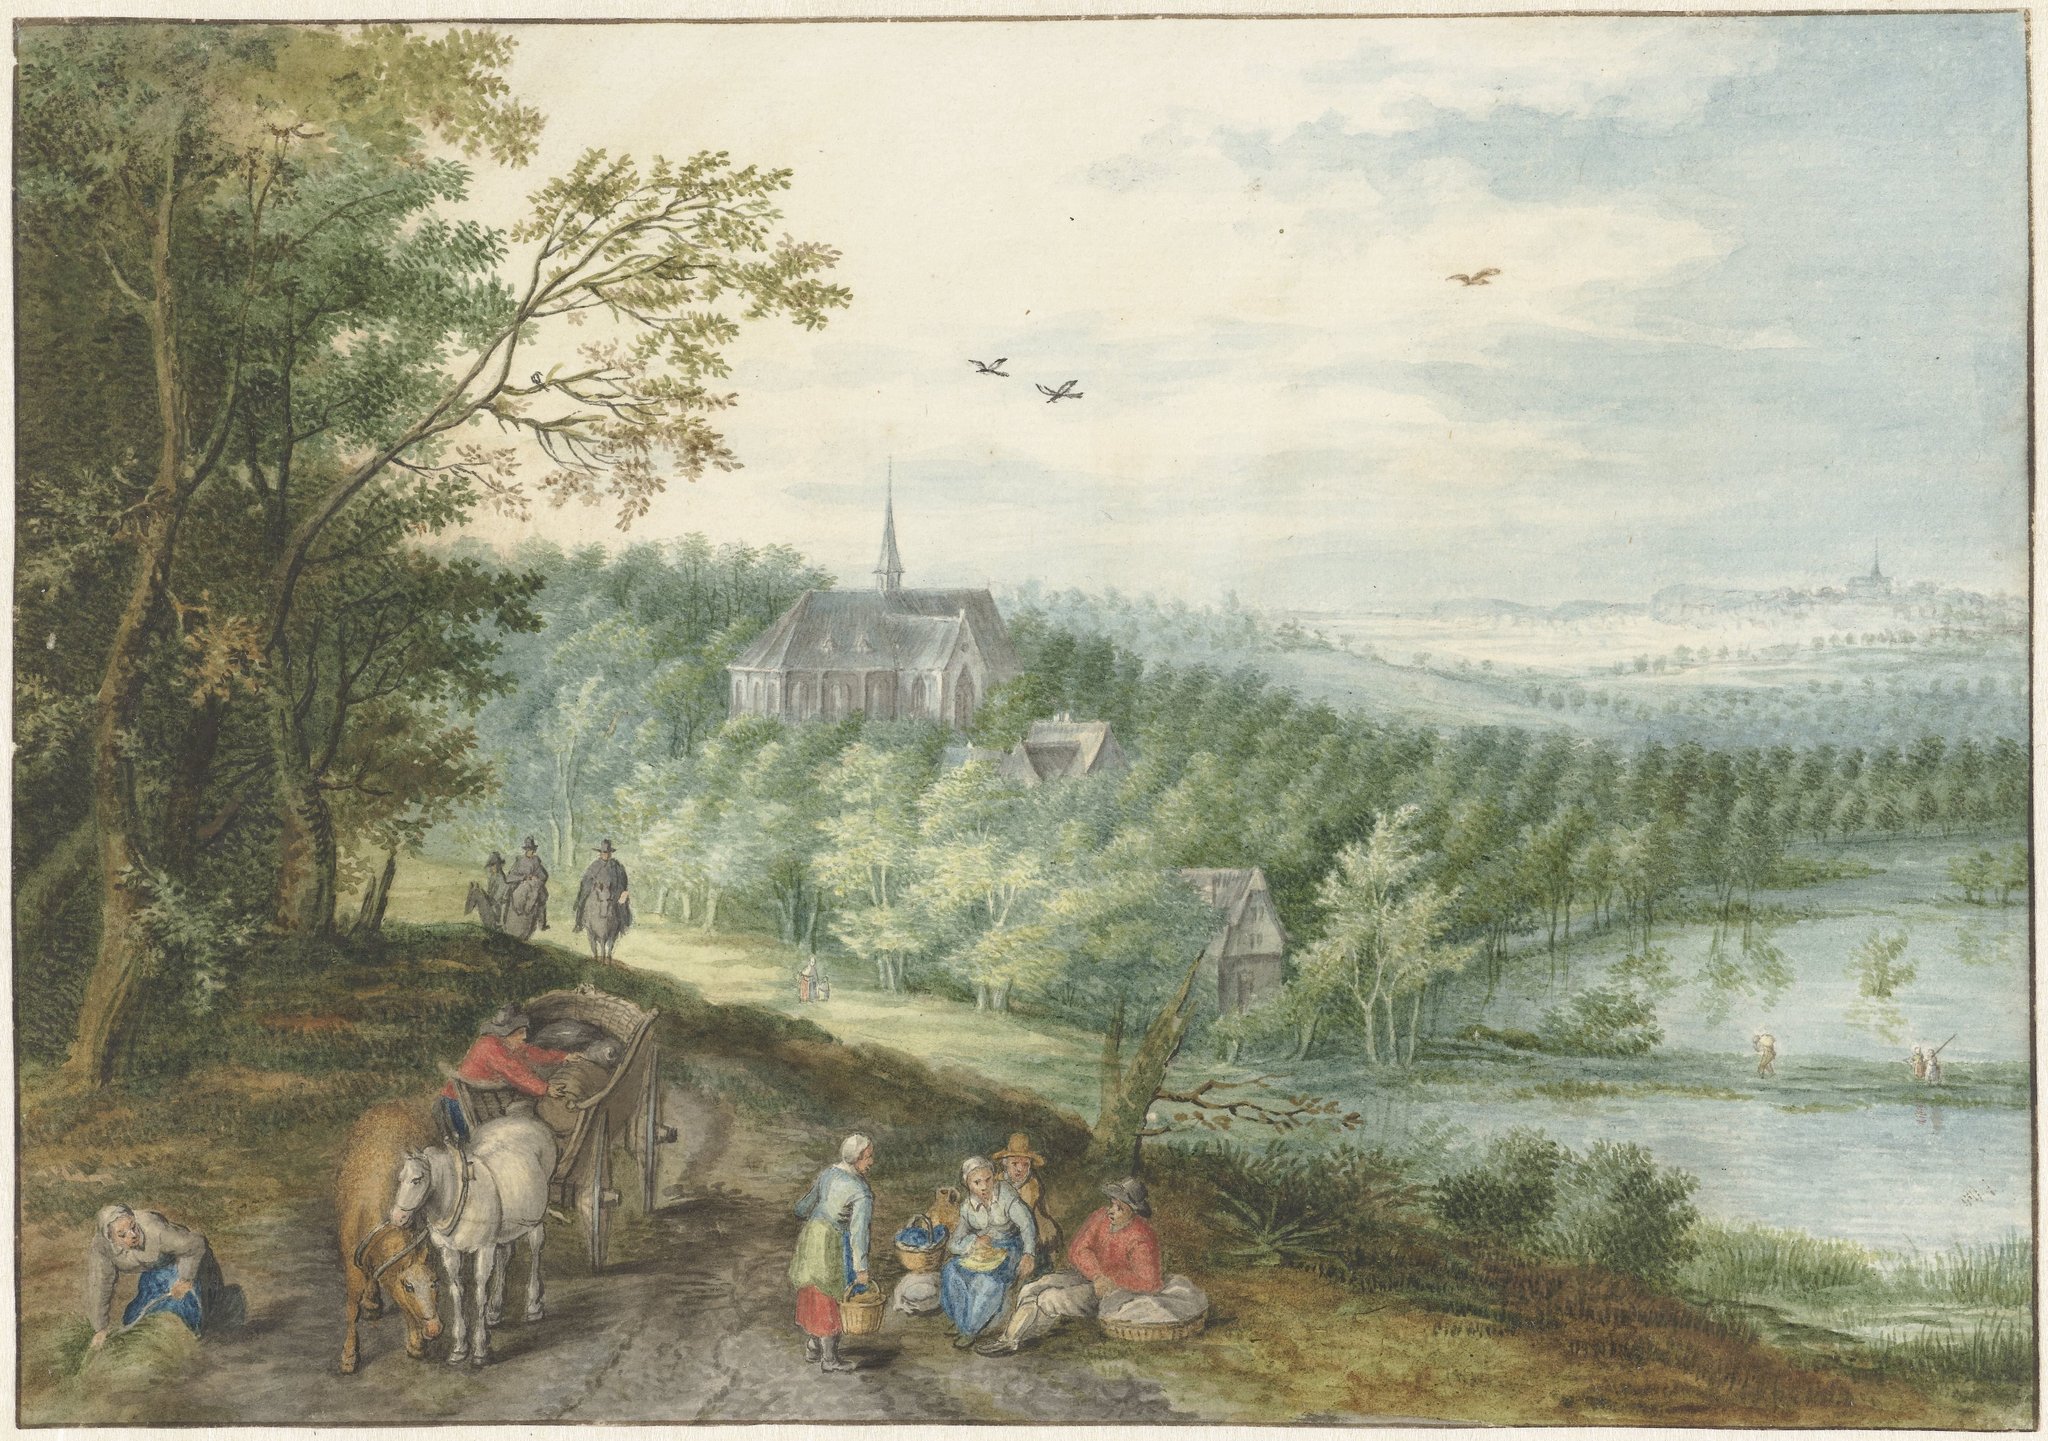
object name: watercolor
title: Landschap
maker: sybrand feitama (ii)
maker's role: draughtsman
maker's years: 1694-1758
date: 1704-1758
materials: ink, paper, watercolor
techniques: brush, pen